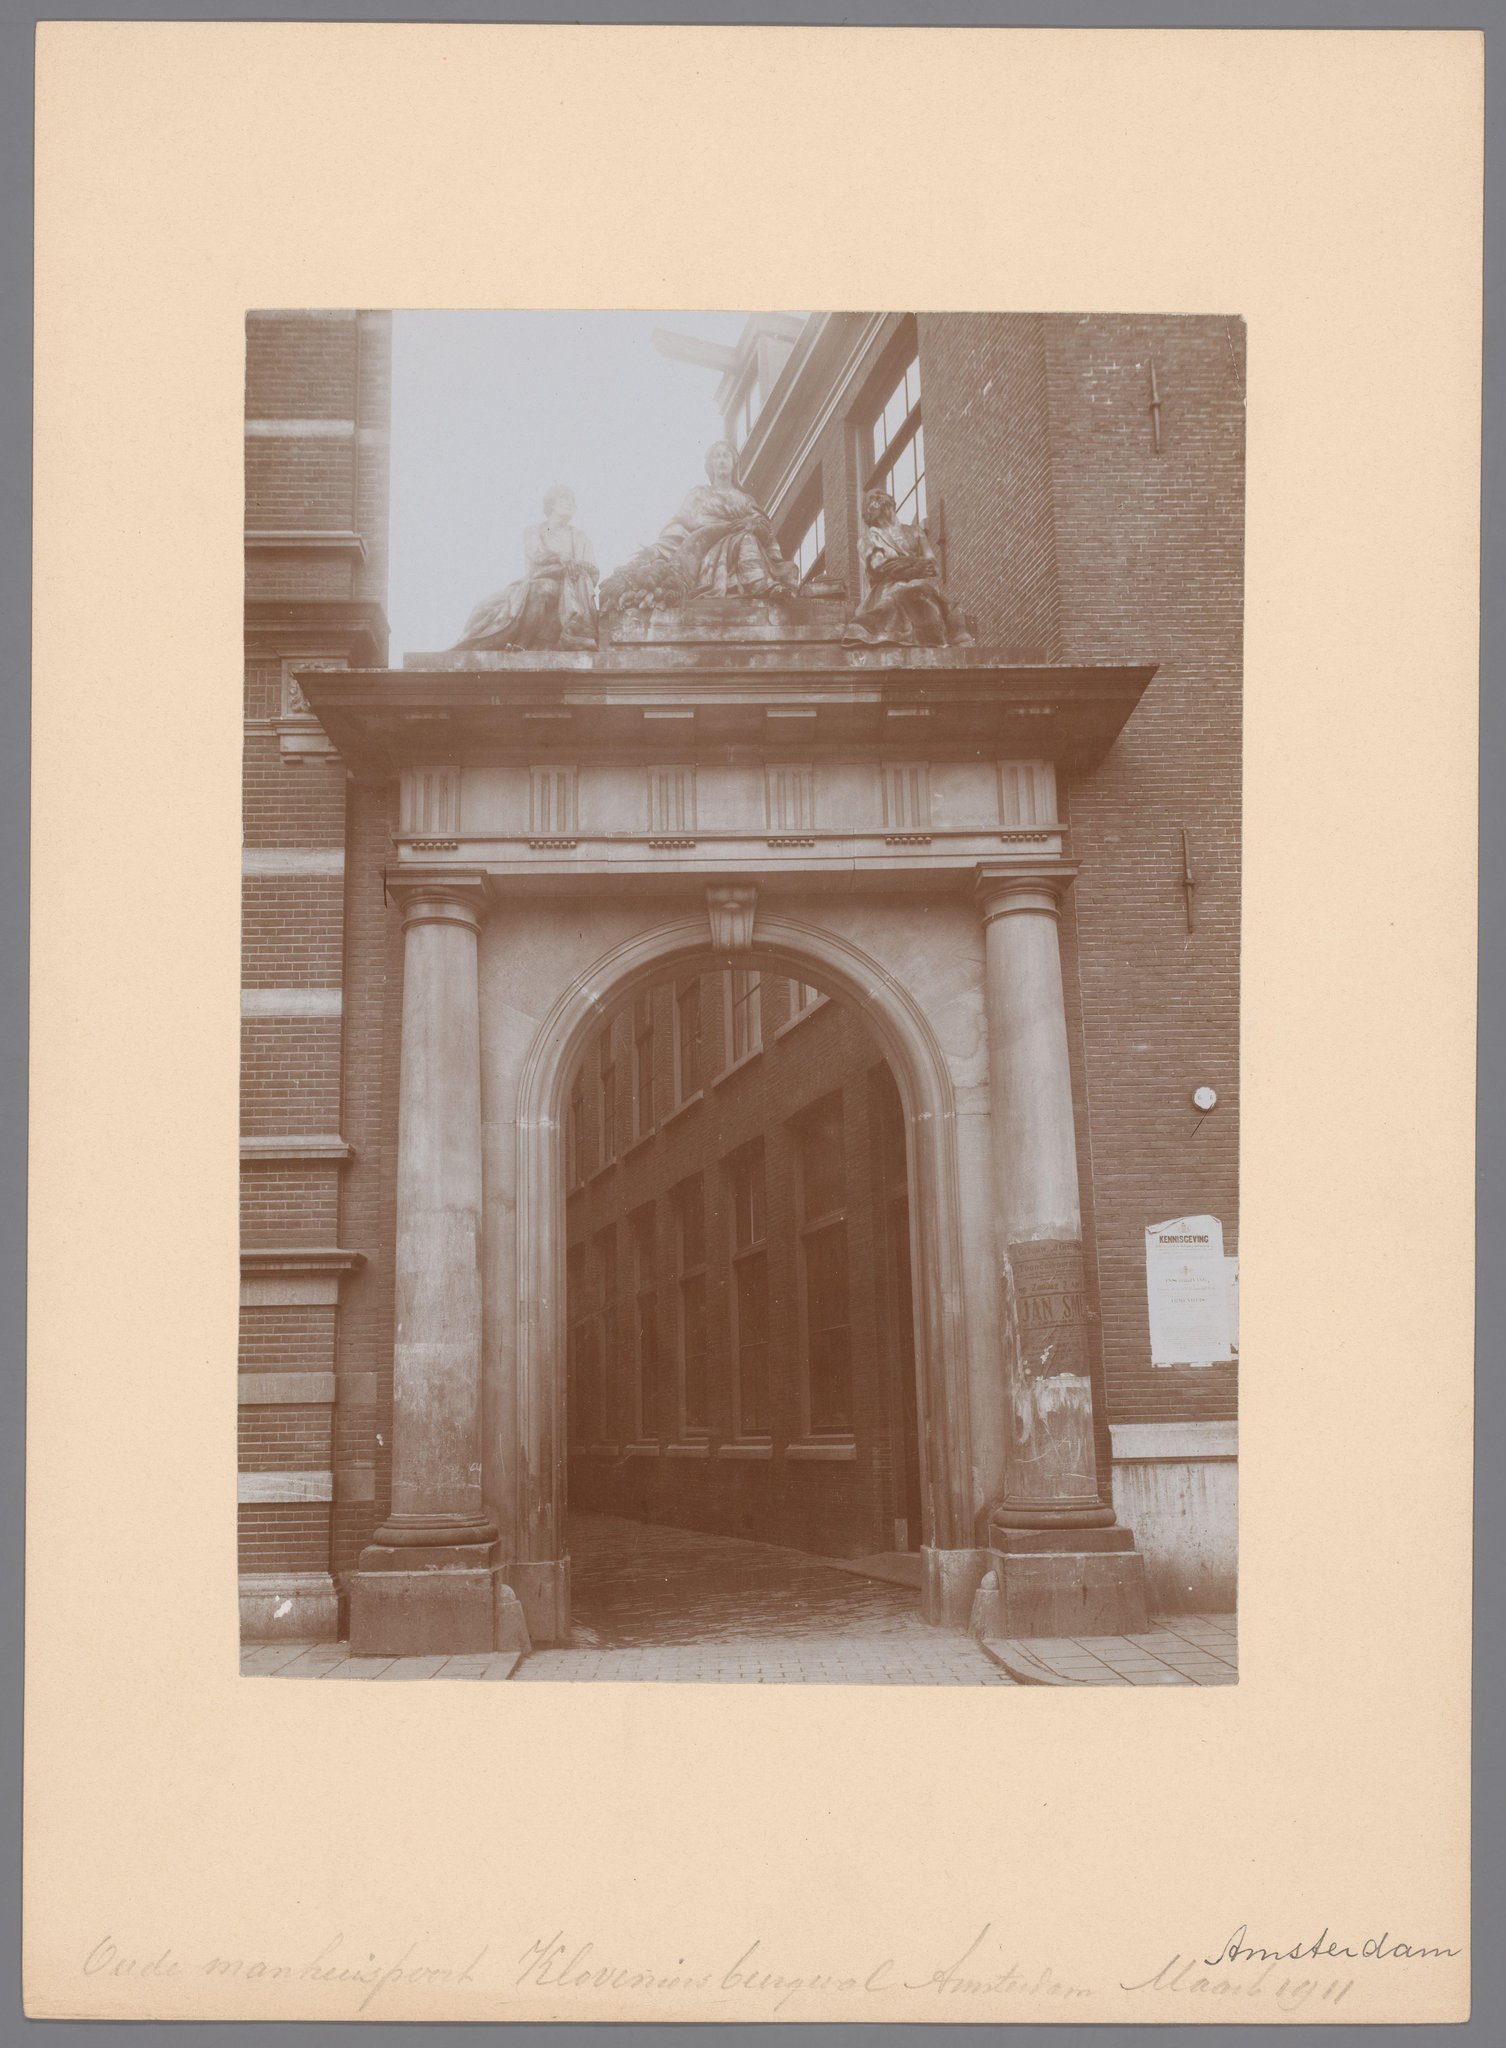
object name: photograph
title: Oudemanhuispoort aan de Kloveniersvoorburgwal te Amsterdam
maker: anoniem (monumentenzorg)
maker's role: fotograaf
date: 1911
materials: cardboard, photographic support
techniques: collodion silver print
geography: kloveniersburgwal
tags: gate, entrance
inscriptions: annotation: ‘Oude manhuispoort Kloveniersburgwal Amsterdam Maart 1911/ Amsterdam’